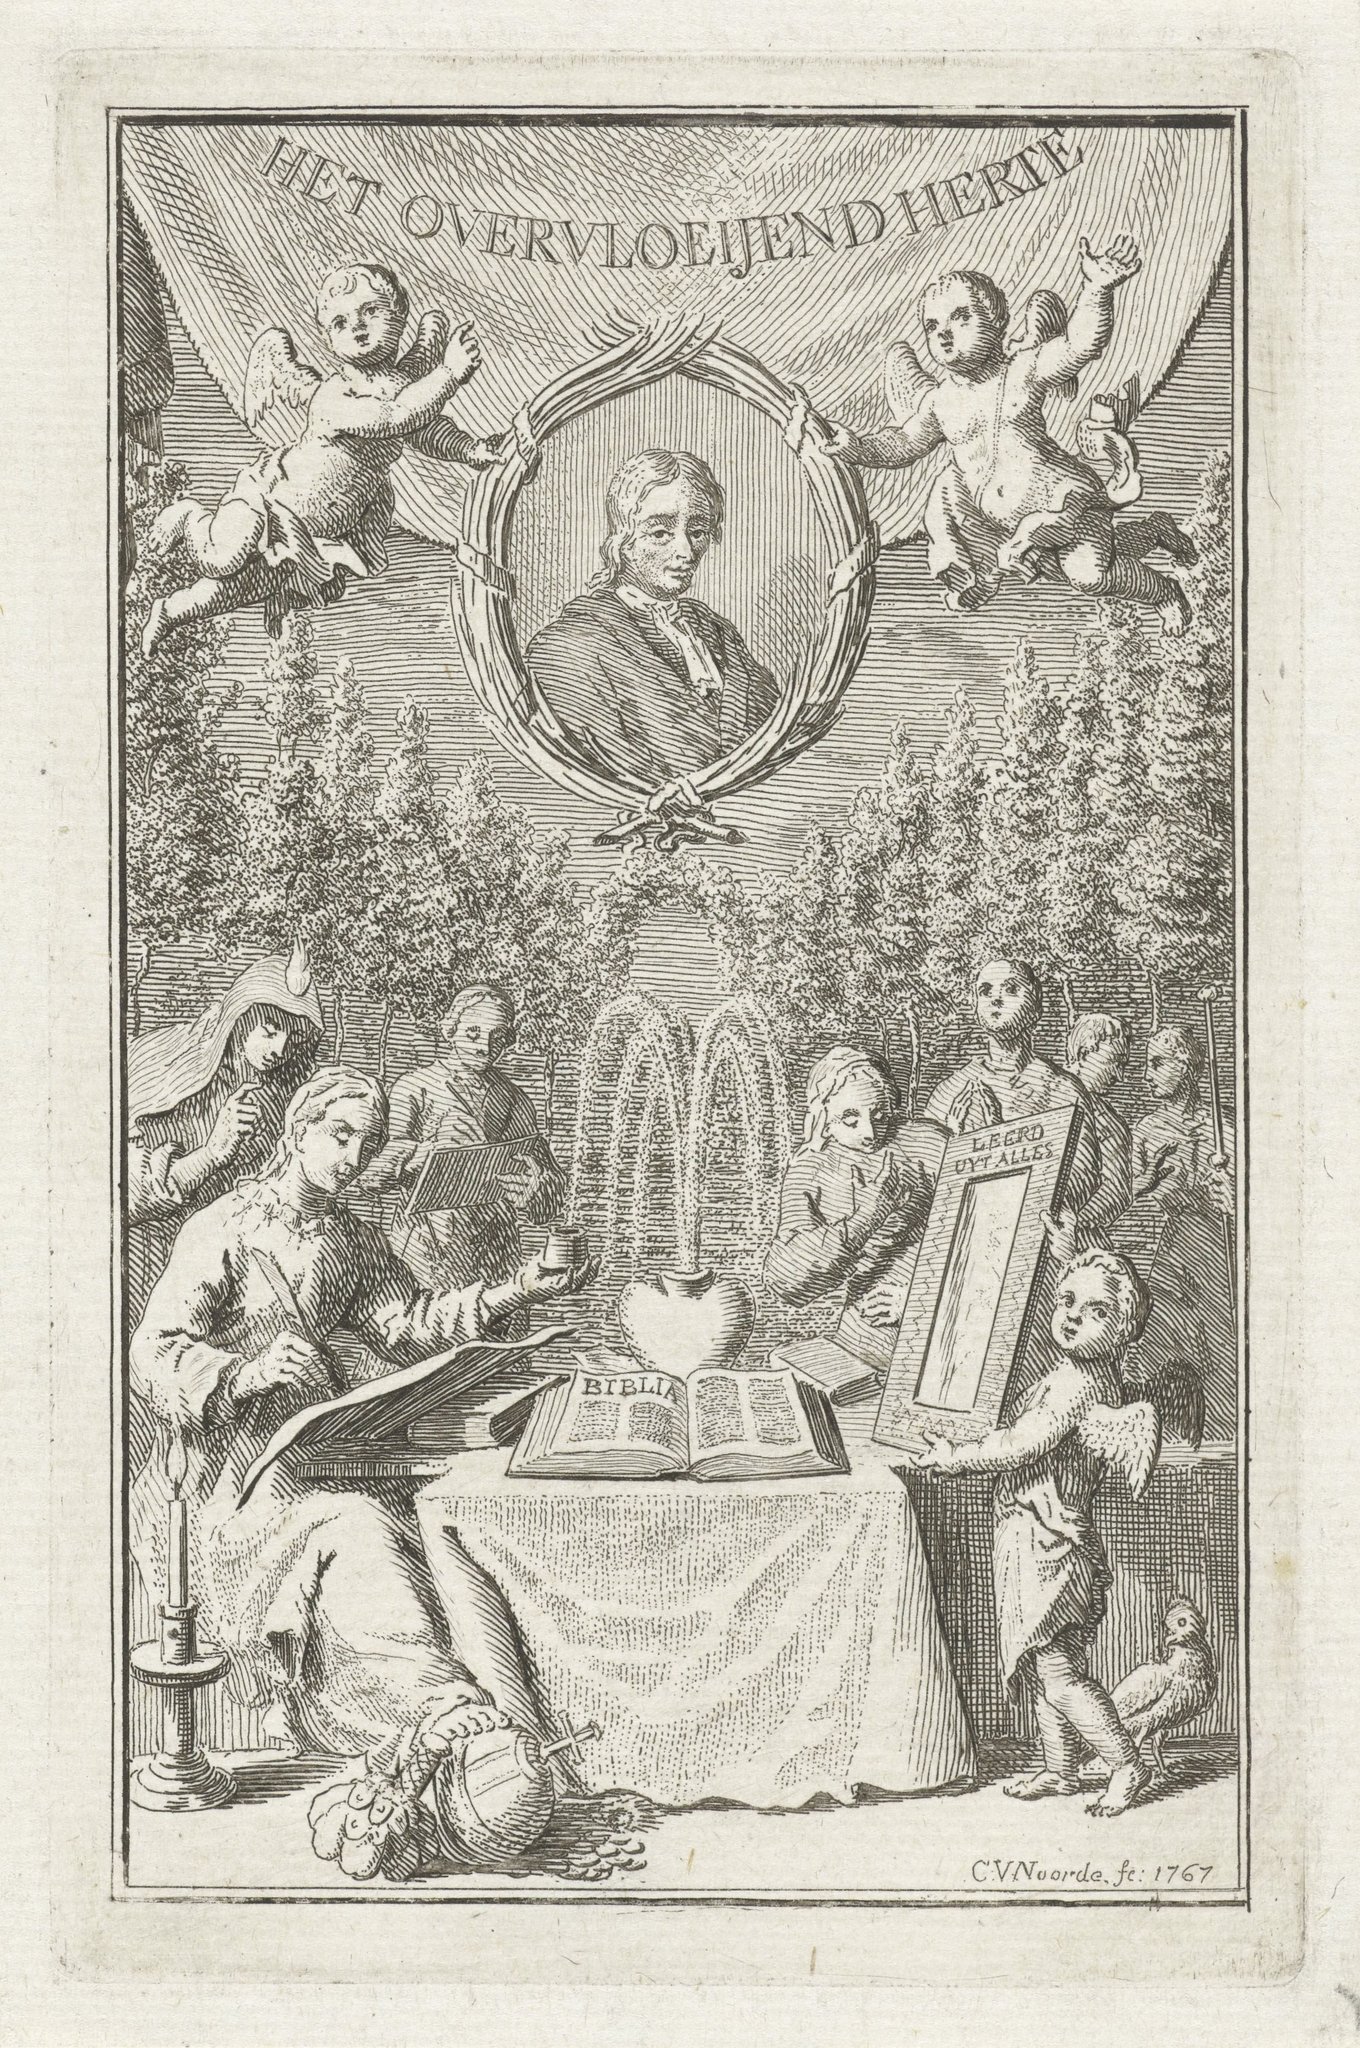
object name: titelblad, titelpagina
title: Overvloeiend hart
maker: cornelis van noorde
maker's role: draughtsman, print maker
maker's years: 1731-1795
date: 1767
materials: paper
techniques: etching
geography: haarlem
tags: simplicity; 'simplicità' (ripa), faith, 'fides'; 'fede', 'fede catholica', 'fede christiana', 'fede christiana catholica' (ripa) ~ one of the three theological virtues, heart symbolism, cupids: 'amores', 'amoretti', 'putti', the bible as a book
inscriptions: collector's mark: Lugt 240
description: Allegorische voorstelling over de goede en goddelijke dingen, die het hart laten overstromen. Een overvloeiend hart als een fontein staat met een opengeslagen bijbel op een tafel. Aan weerszijden van de tafel staan Godsdienst met een vlam op het hoofd, een kaars, die zorgt voor licht, de Eenvoud, die een spiegel toont met de tekst: Leert uit alles. De Tekenkunst schetst het goede. Bovenaan, gedragen door putti, het portret van de schrijver Jan Luyken.